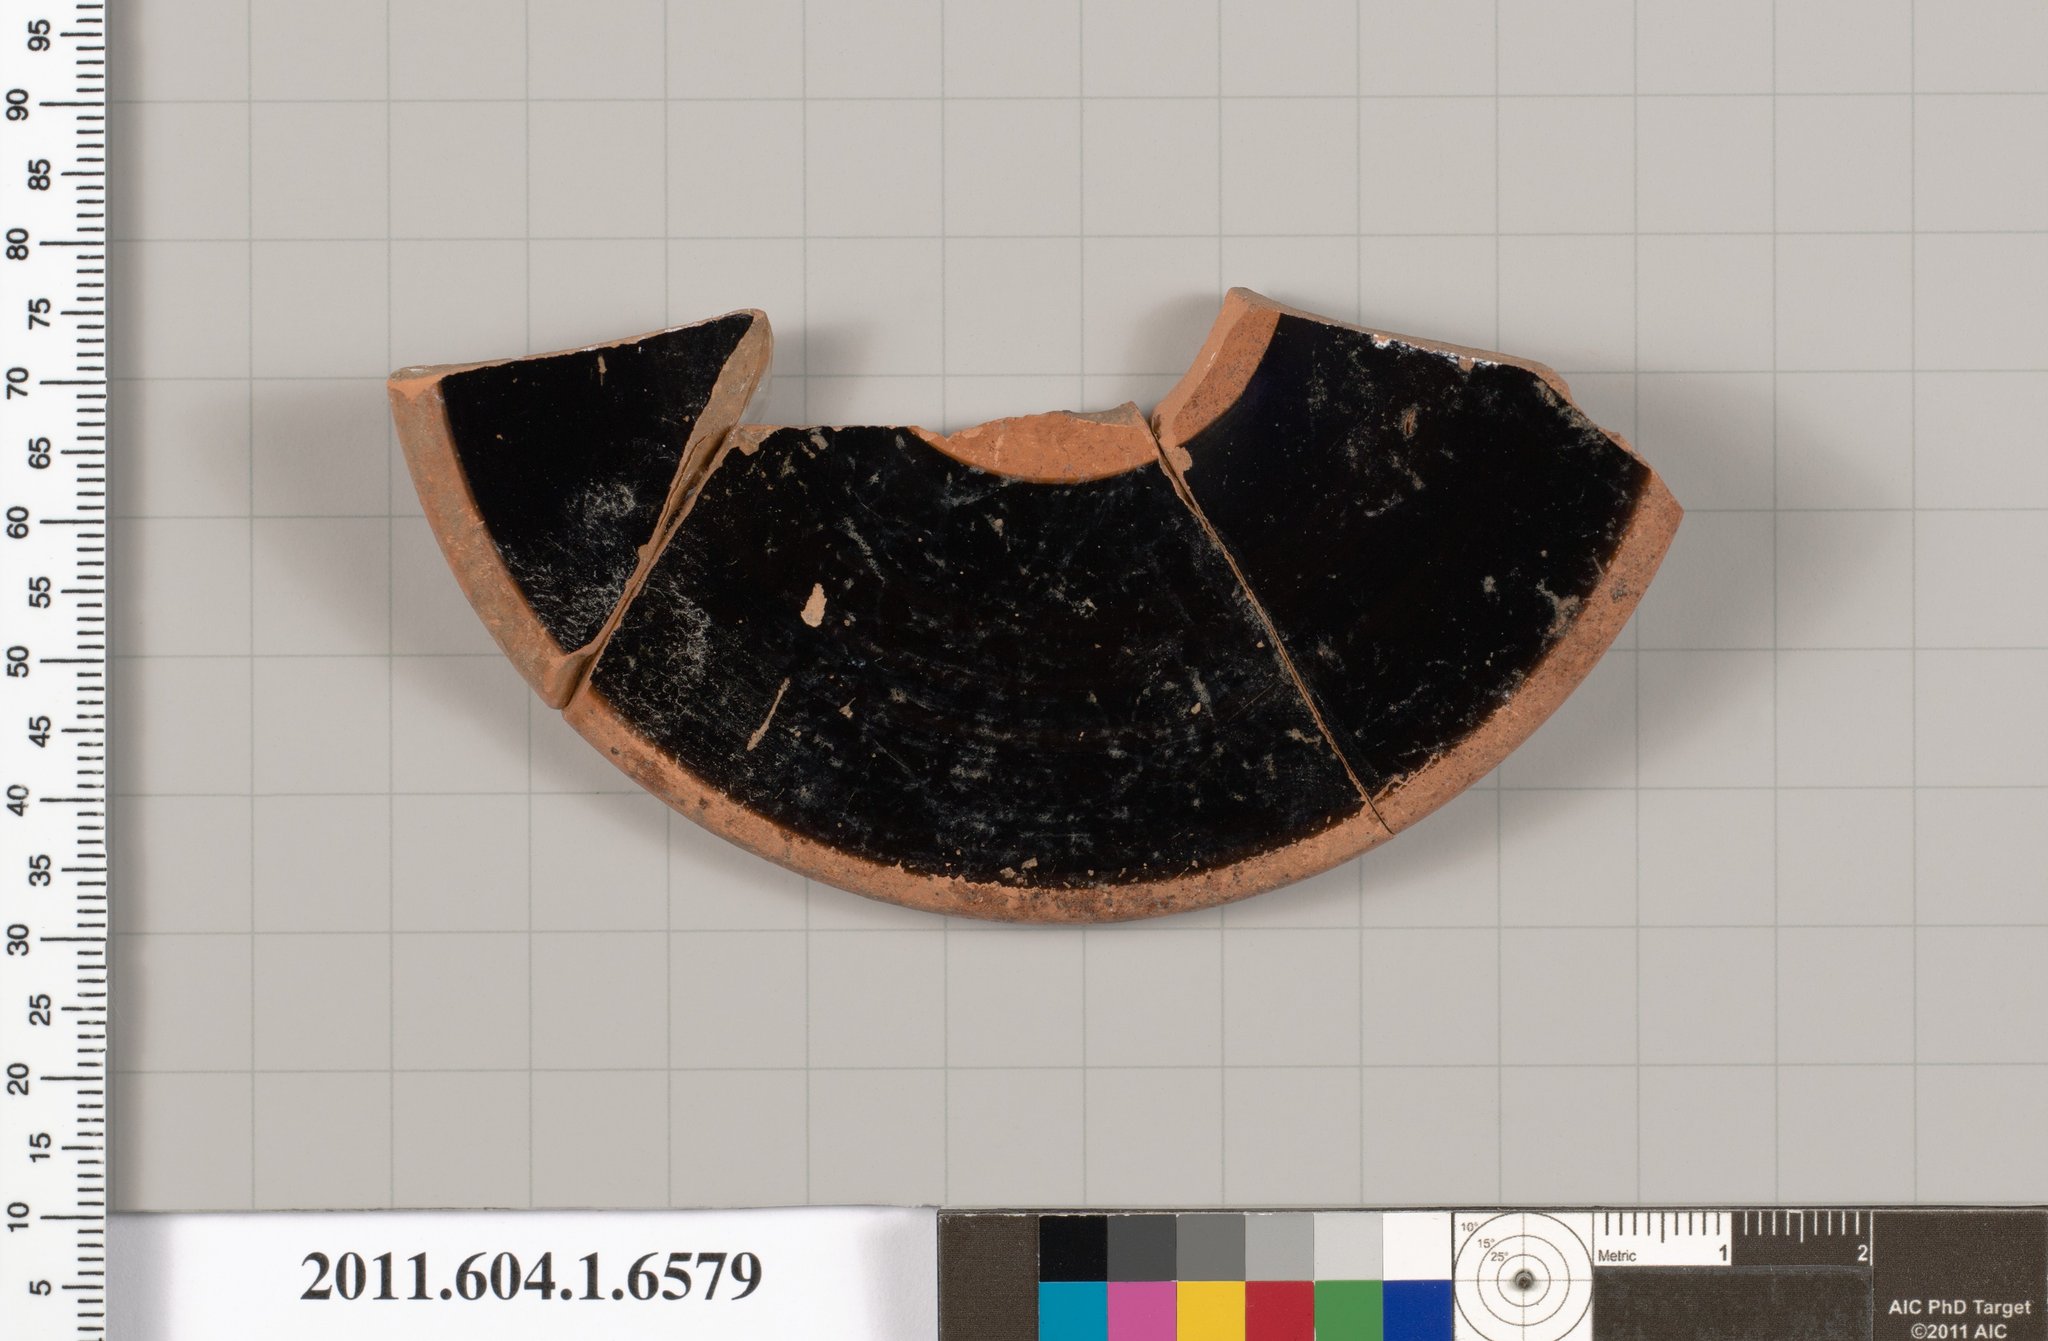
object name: kylix fragment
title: Terracotta fragment of a kylix (drinking cup)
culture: greek, attic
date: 490-480 BCE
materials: terracotta